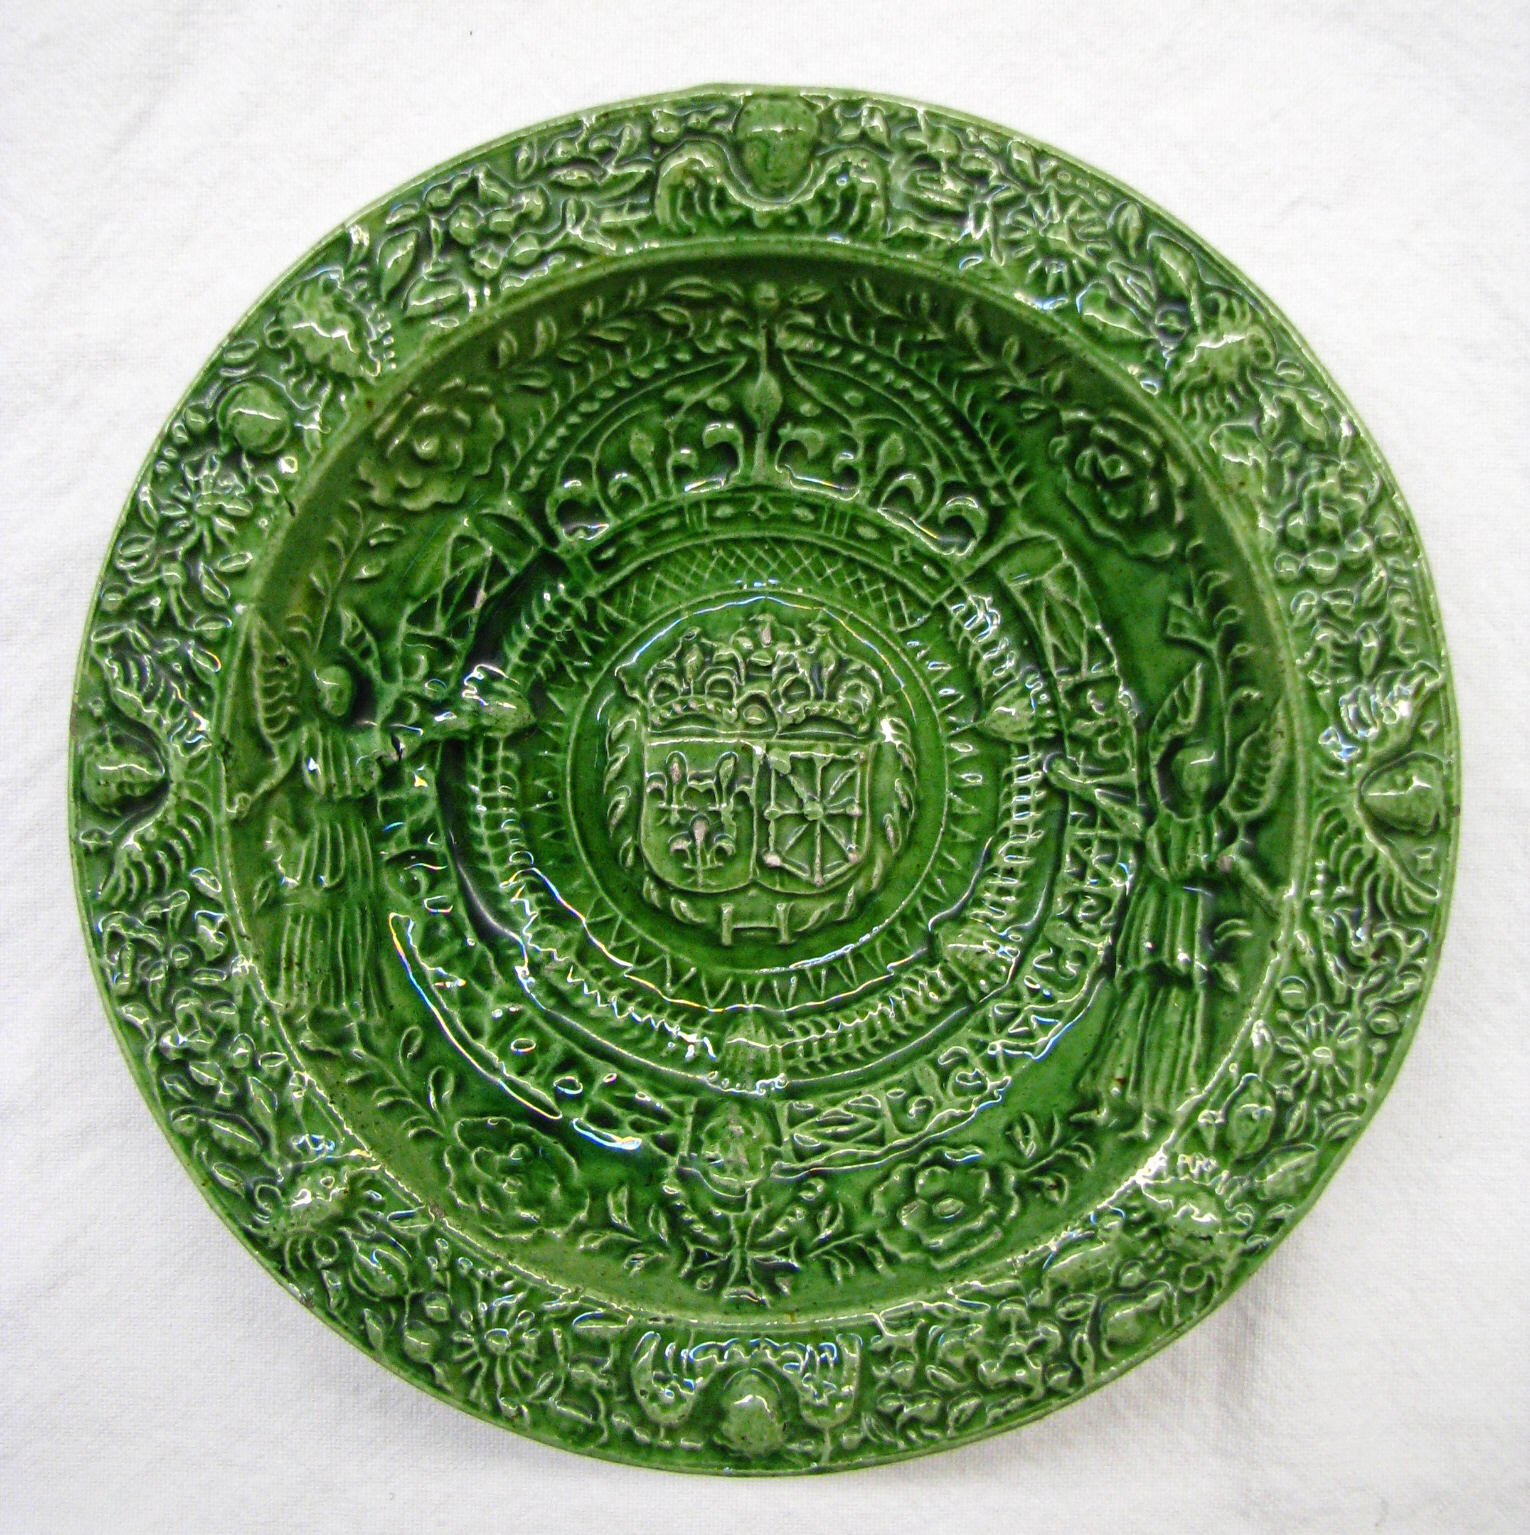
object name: bowl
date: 1600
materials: earthenware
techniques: glazing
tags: coat of arms